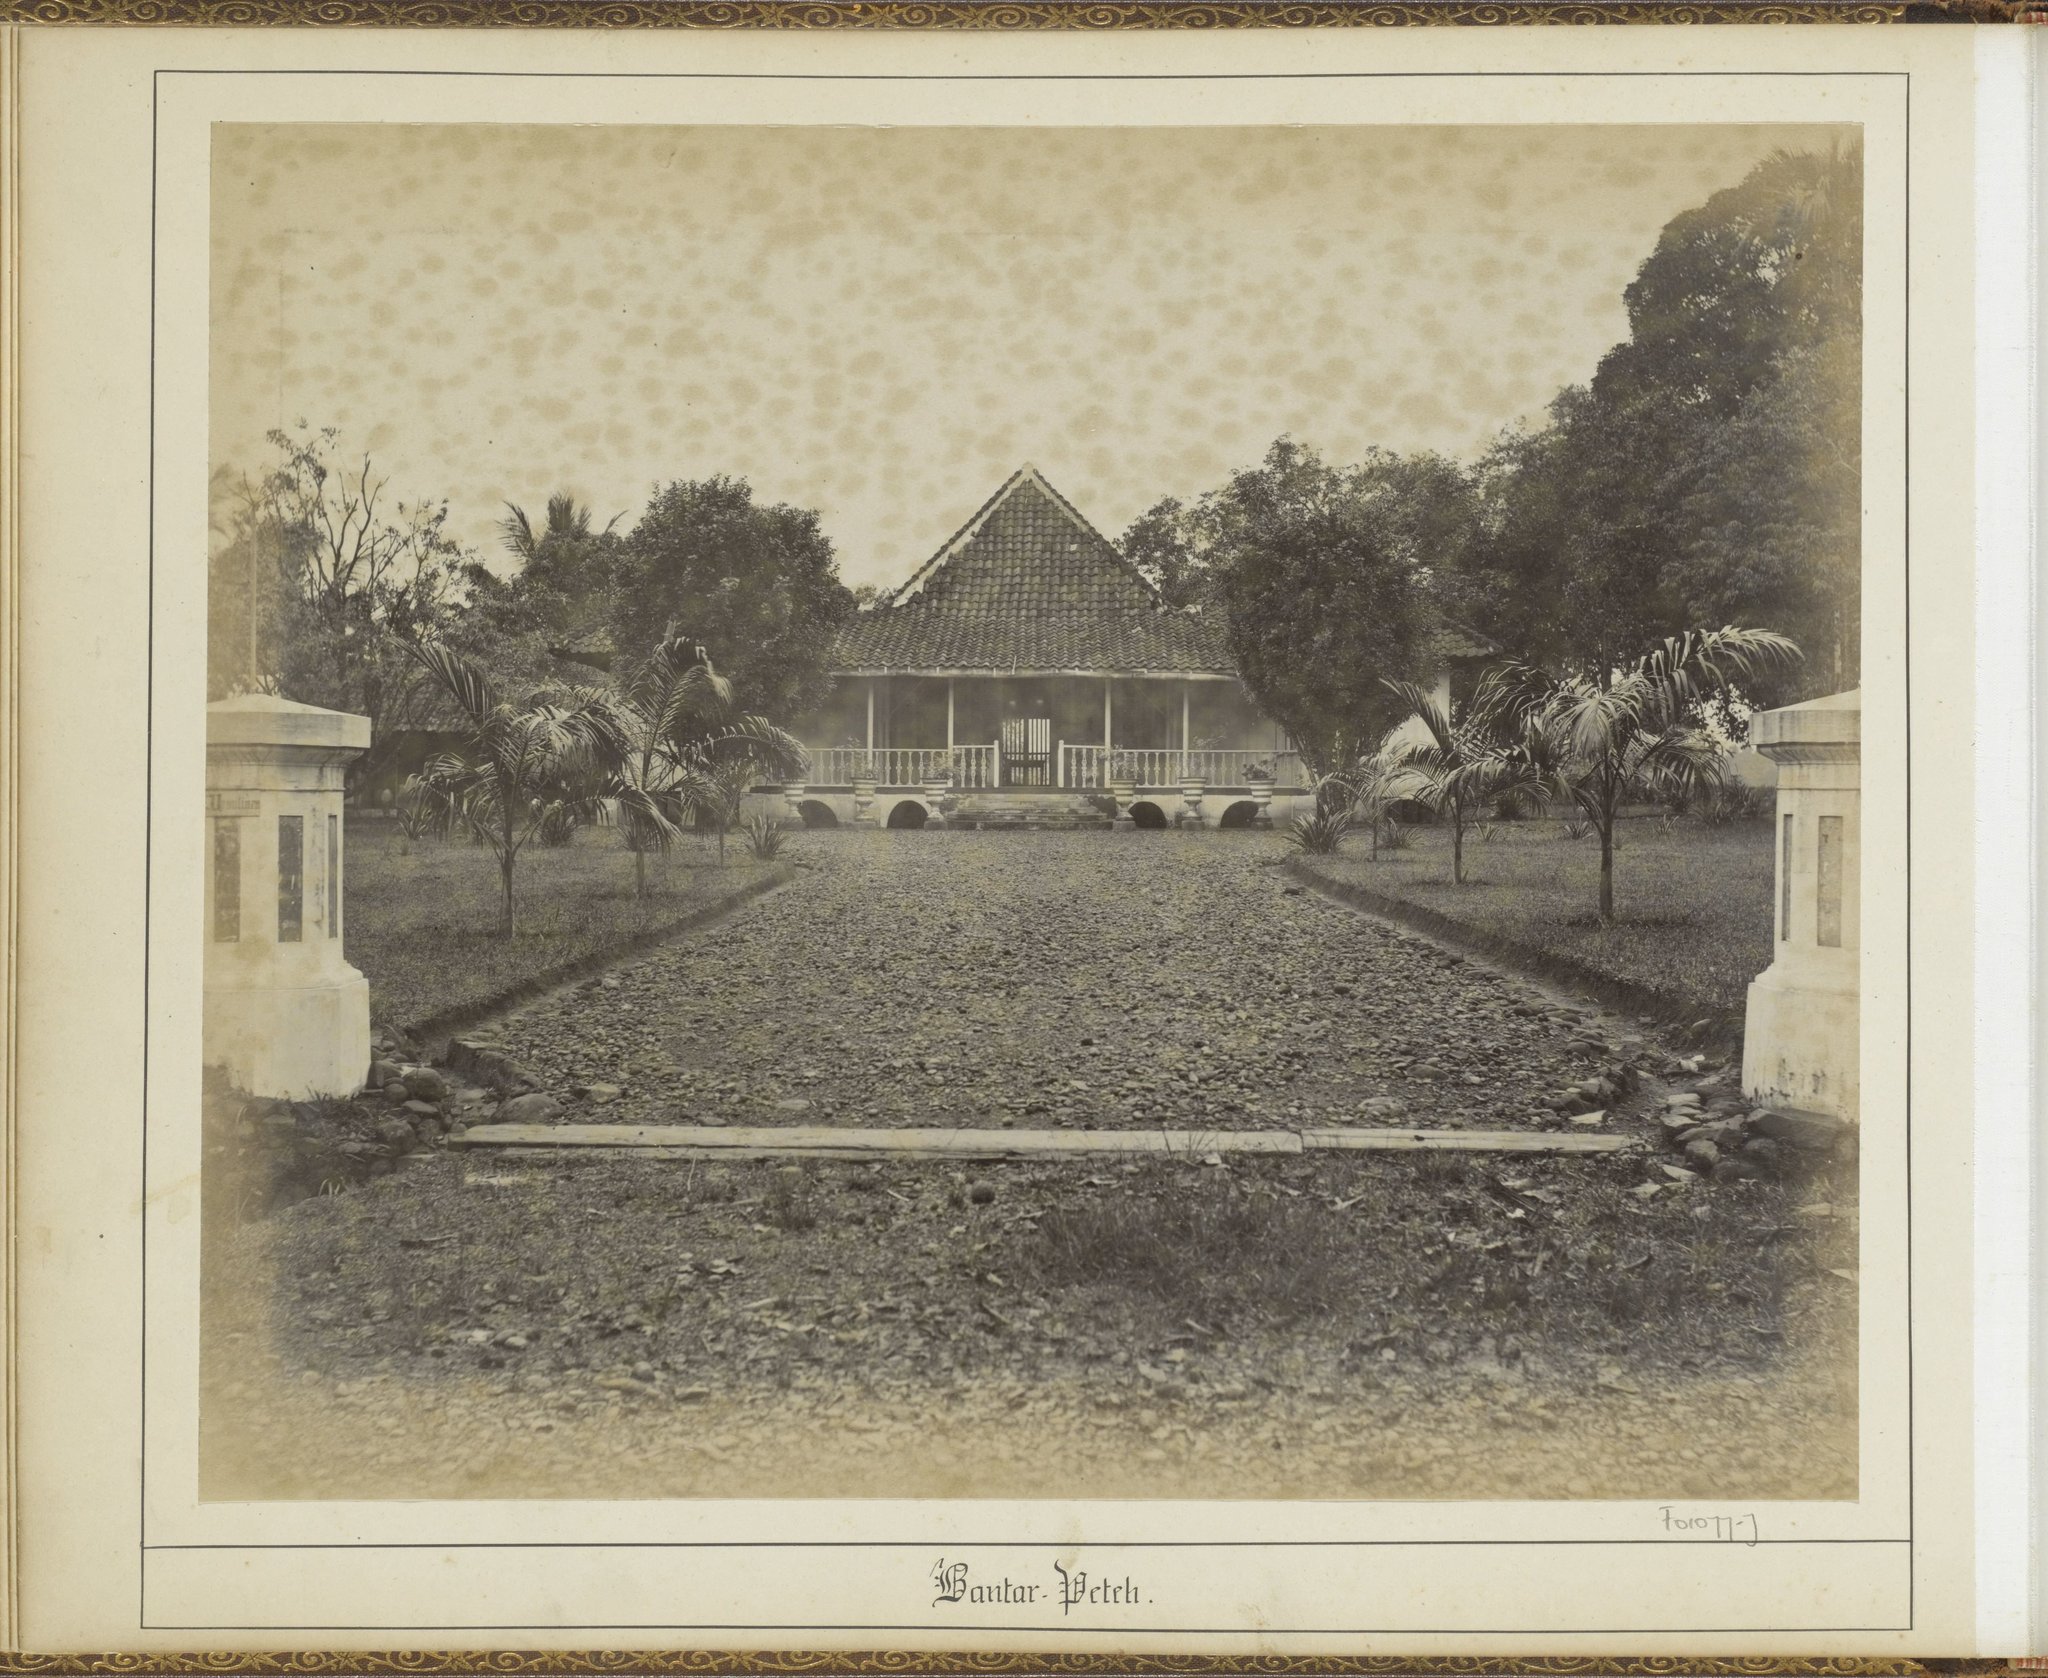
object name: photograph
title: Tuin met een huis in Bantar-Peteh bij Buitenzorg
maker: Anonymous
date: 1890-1910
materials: cardboard, photographic support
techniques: albumen print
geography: buitenzorg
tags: garden, batavia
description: Onderdeel van Album met foto's van Batavia en van de zusters Ursulinen.